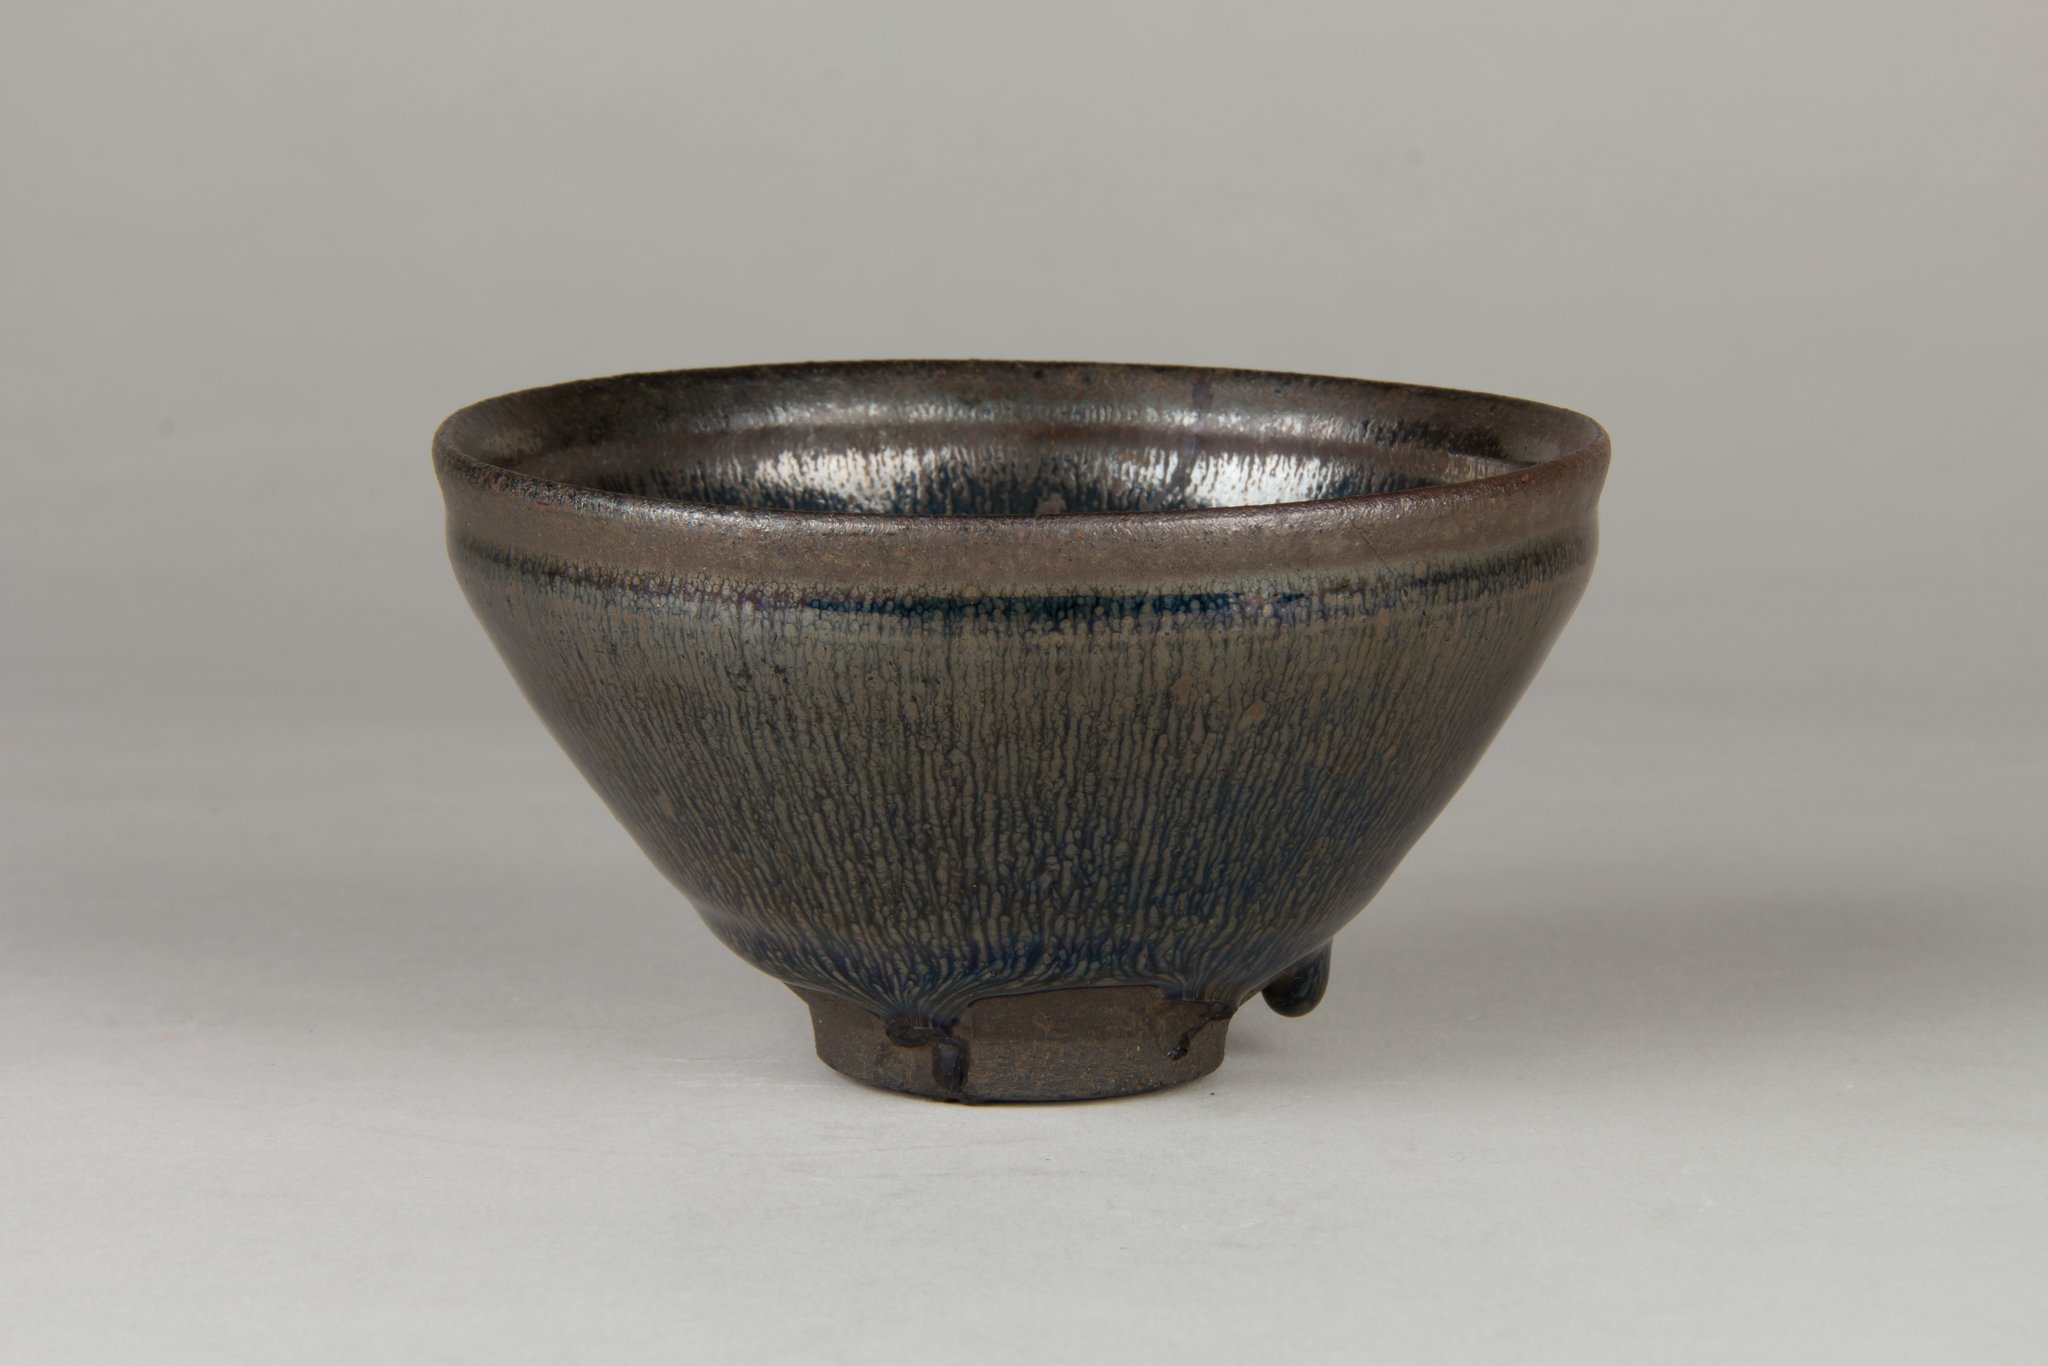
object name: bowl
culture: chinese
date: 960-1279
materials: pottery